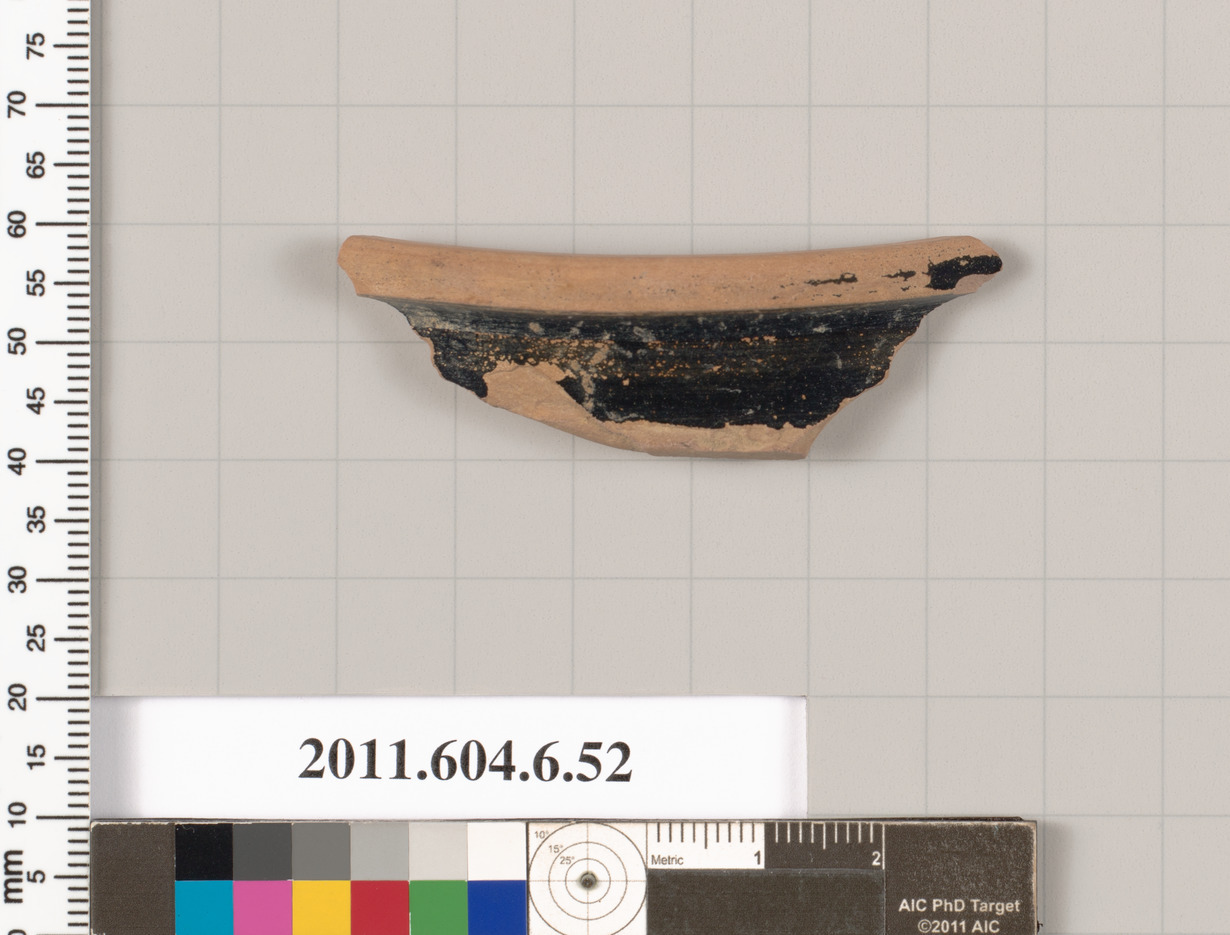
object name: undetermined shape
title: Terracotta rim fragment of an undetermined shape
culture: greek, attic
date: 600-401 BCE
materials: terracotta